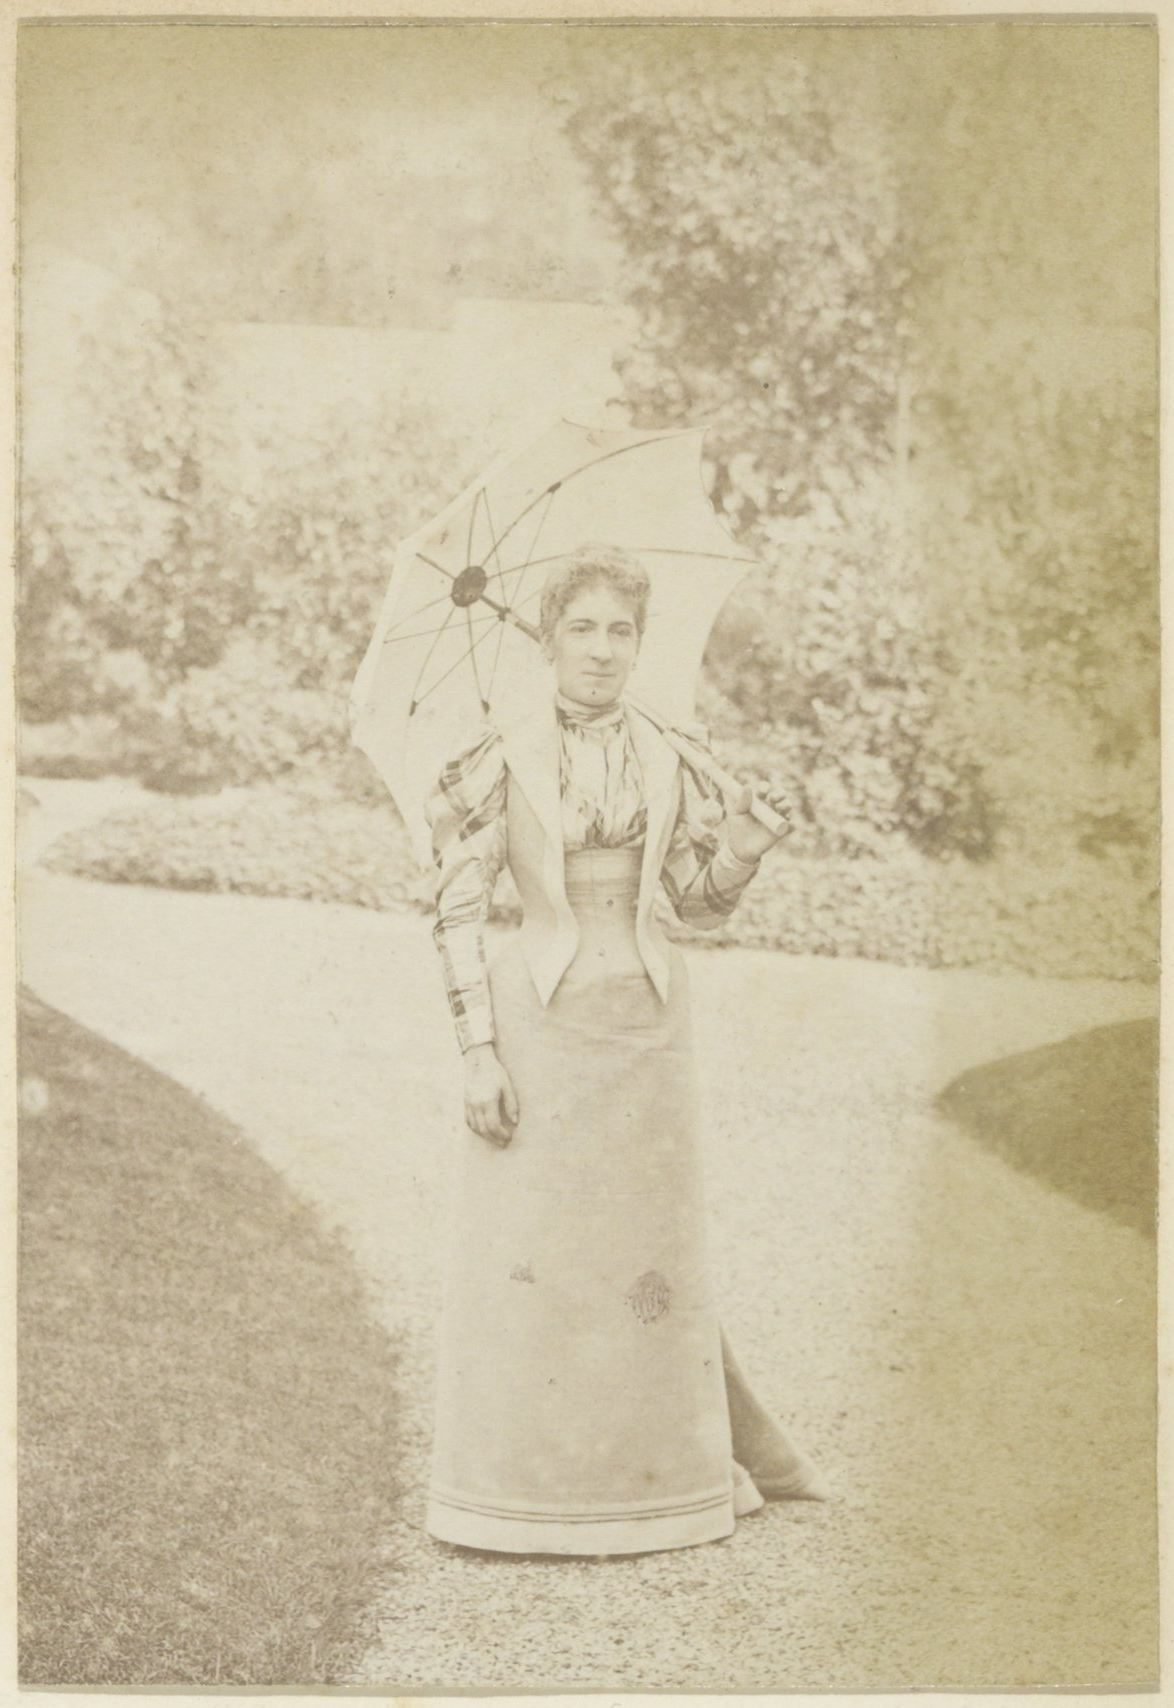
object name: photograph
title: Portret van een Franse vrouw met een paraplu op een tuinpad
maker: Anonymous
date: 1900-1910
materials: paper, photographic support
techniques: albumen print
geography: france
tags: adult woman, garden, umbrella, france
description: Onderdeel van Fotoalbum van een Franse amateurfotograaf met opnames van een familie, distilleerderij Delizy & Doistau Fils, het leger en bezienswaardigheden in Frankrijk.